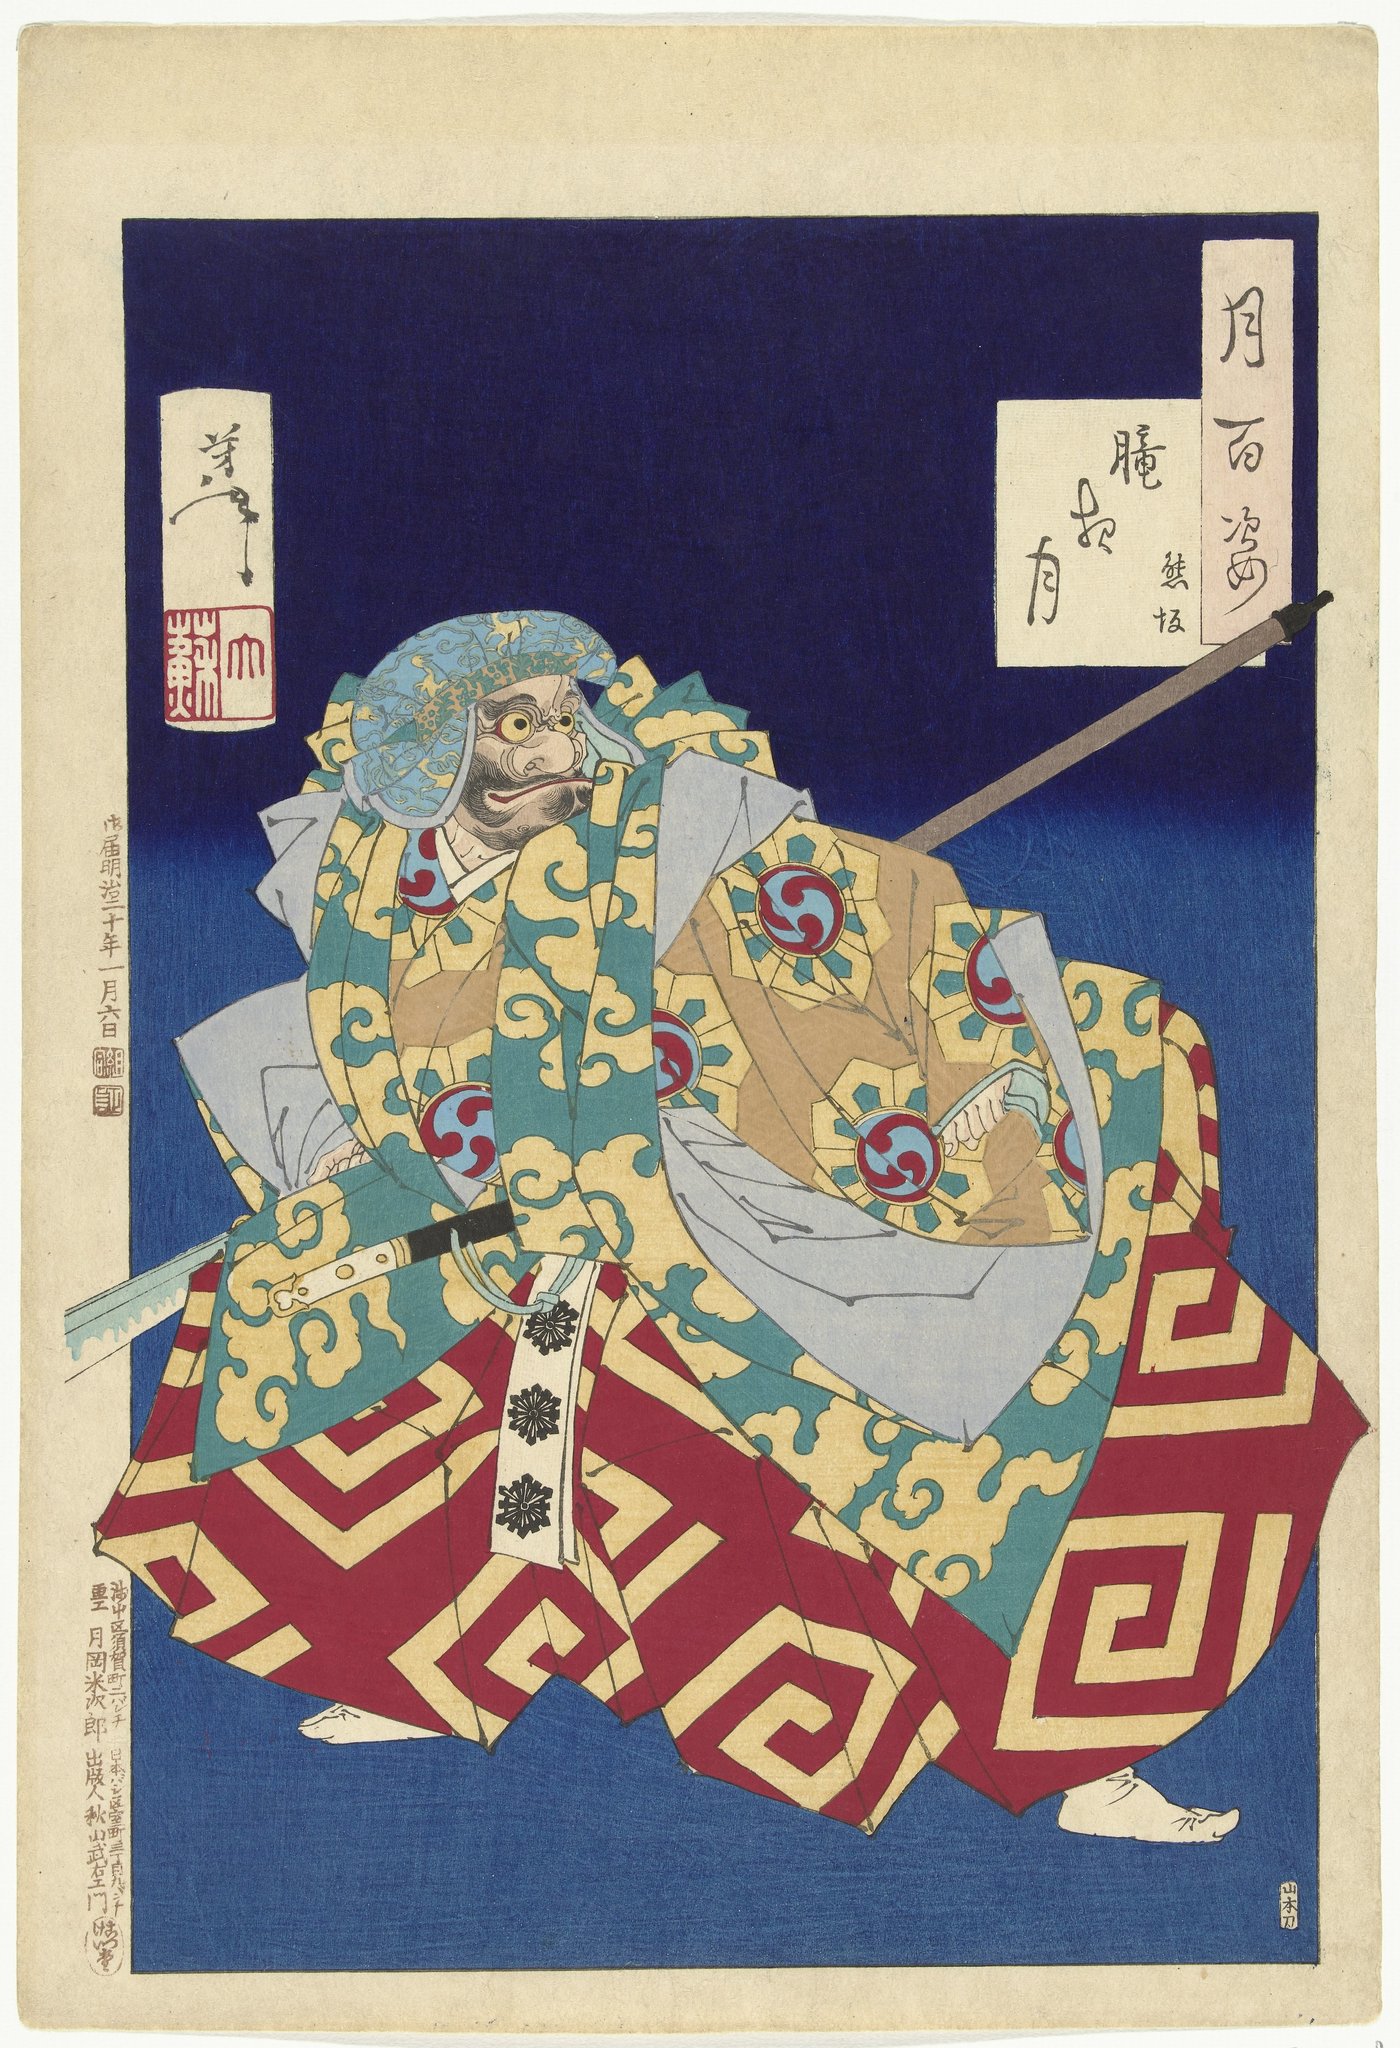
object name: print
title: Tsuki hyakushi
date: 1887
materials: paper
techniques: woodcut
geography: tokyo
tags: spirit, ghost, helved weapons, polearms (for striking, hacking, thrusting): halberd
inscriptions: date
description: Geest verkleed met noh masker en uitbundig geel, rood en groen gekleurd noh kostuum, een hellebaard in zijn rechter hand houdend; tegen donker blauwe achtergrond.